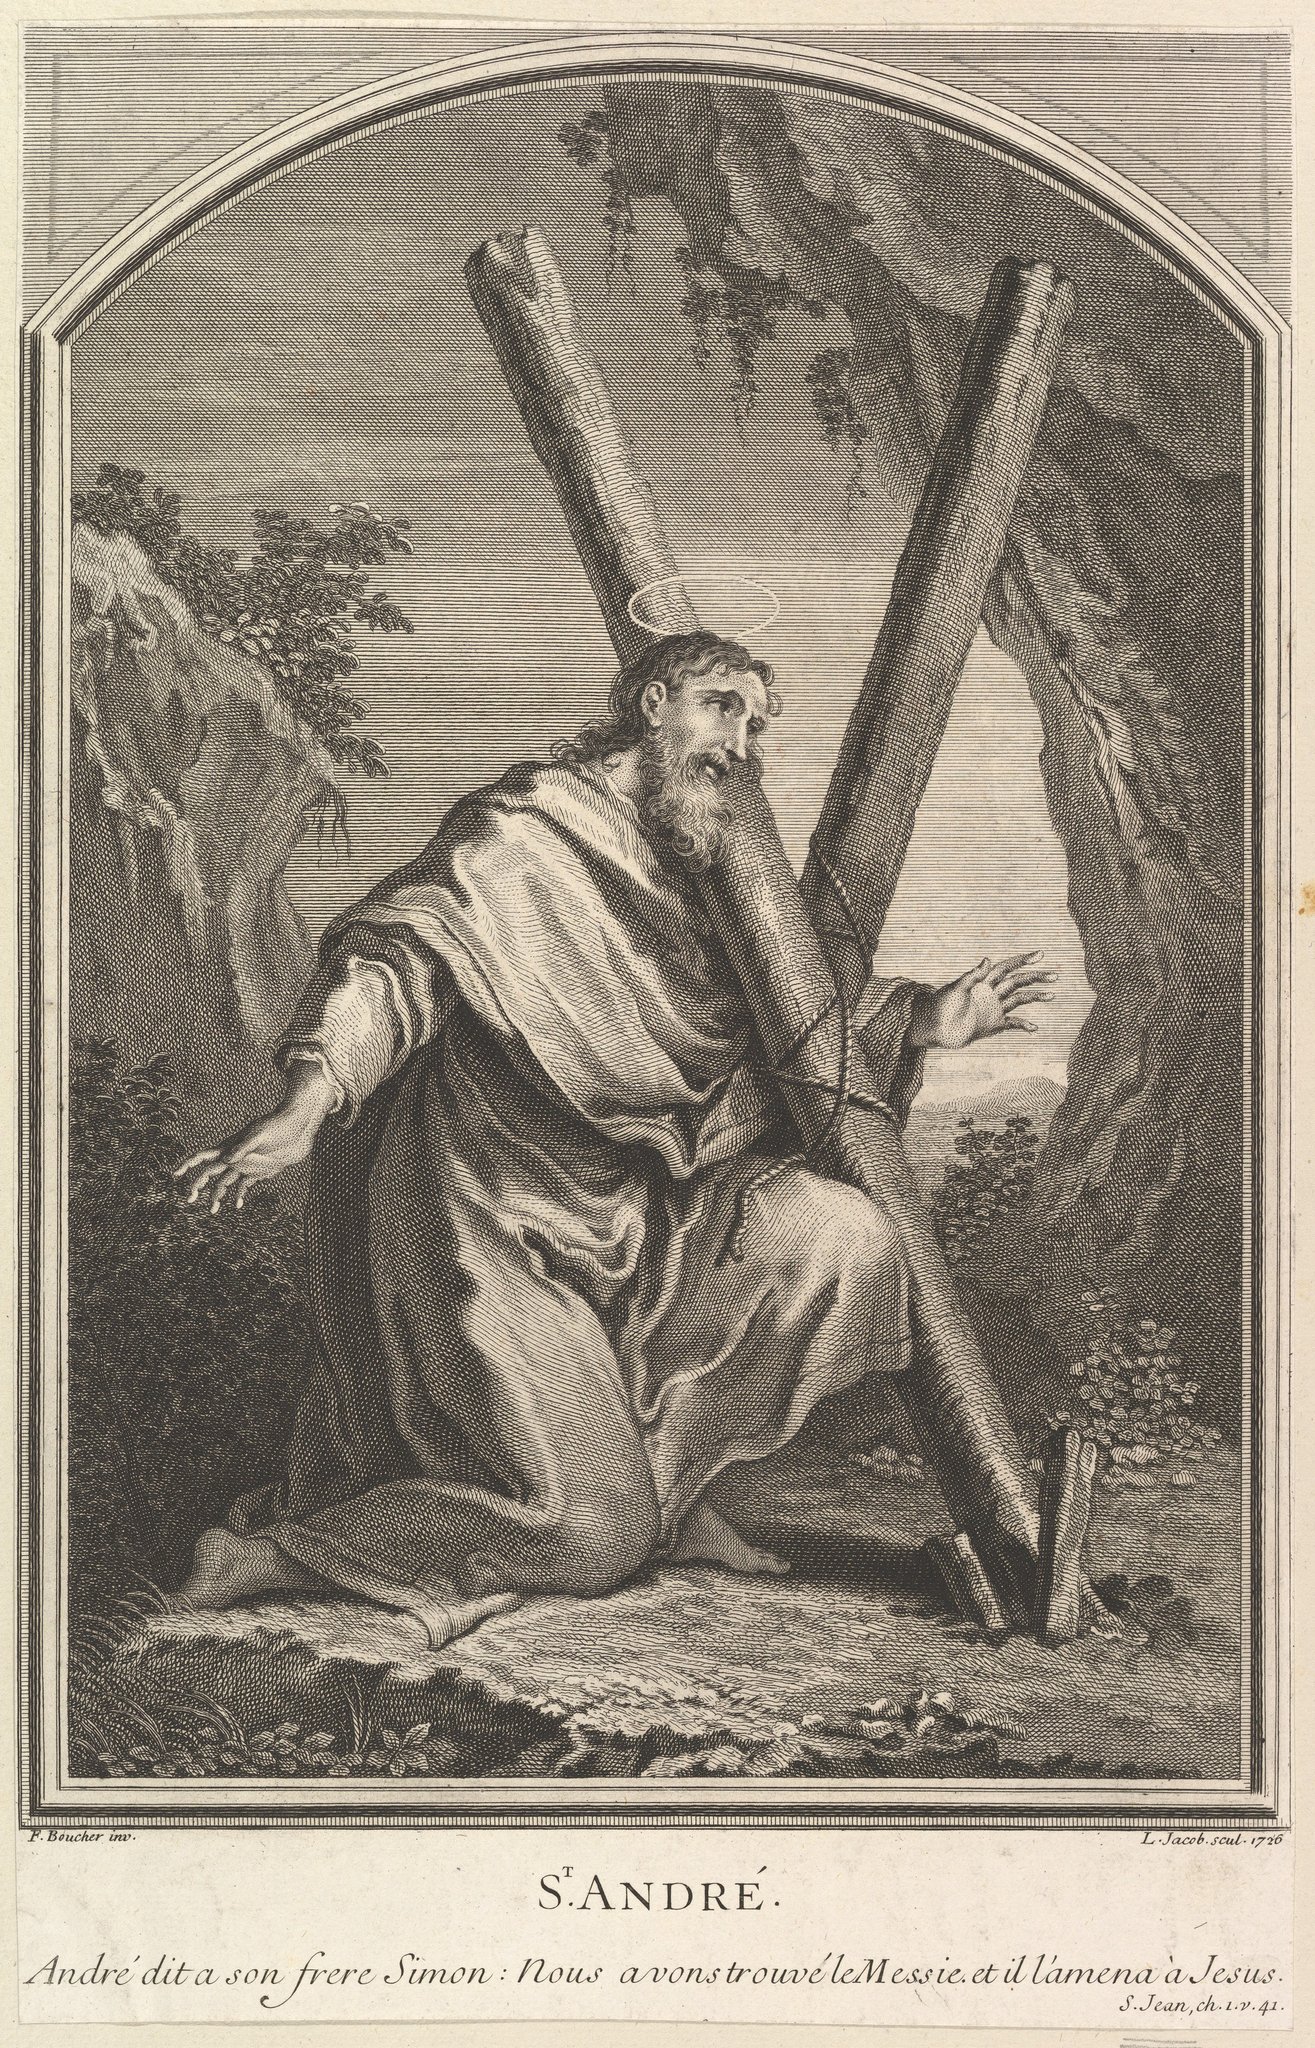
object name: print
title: Saint André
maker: louis jacob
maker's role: artist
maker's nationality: french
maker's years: 1712-1802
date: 1726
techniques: engraving, etching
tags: men,saints